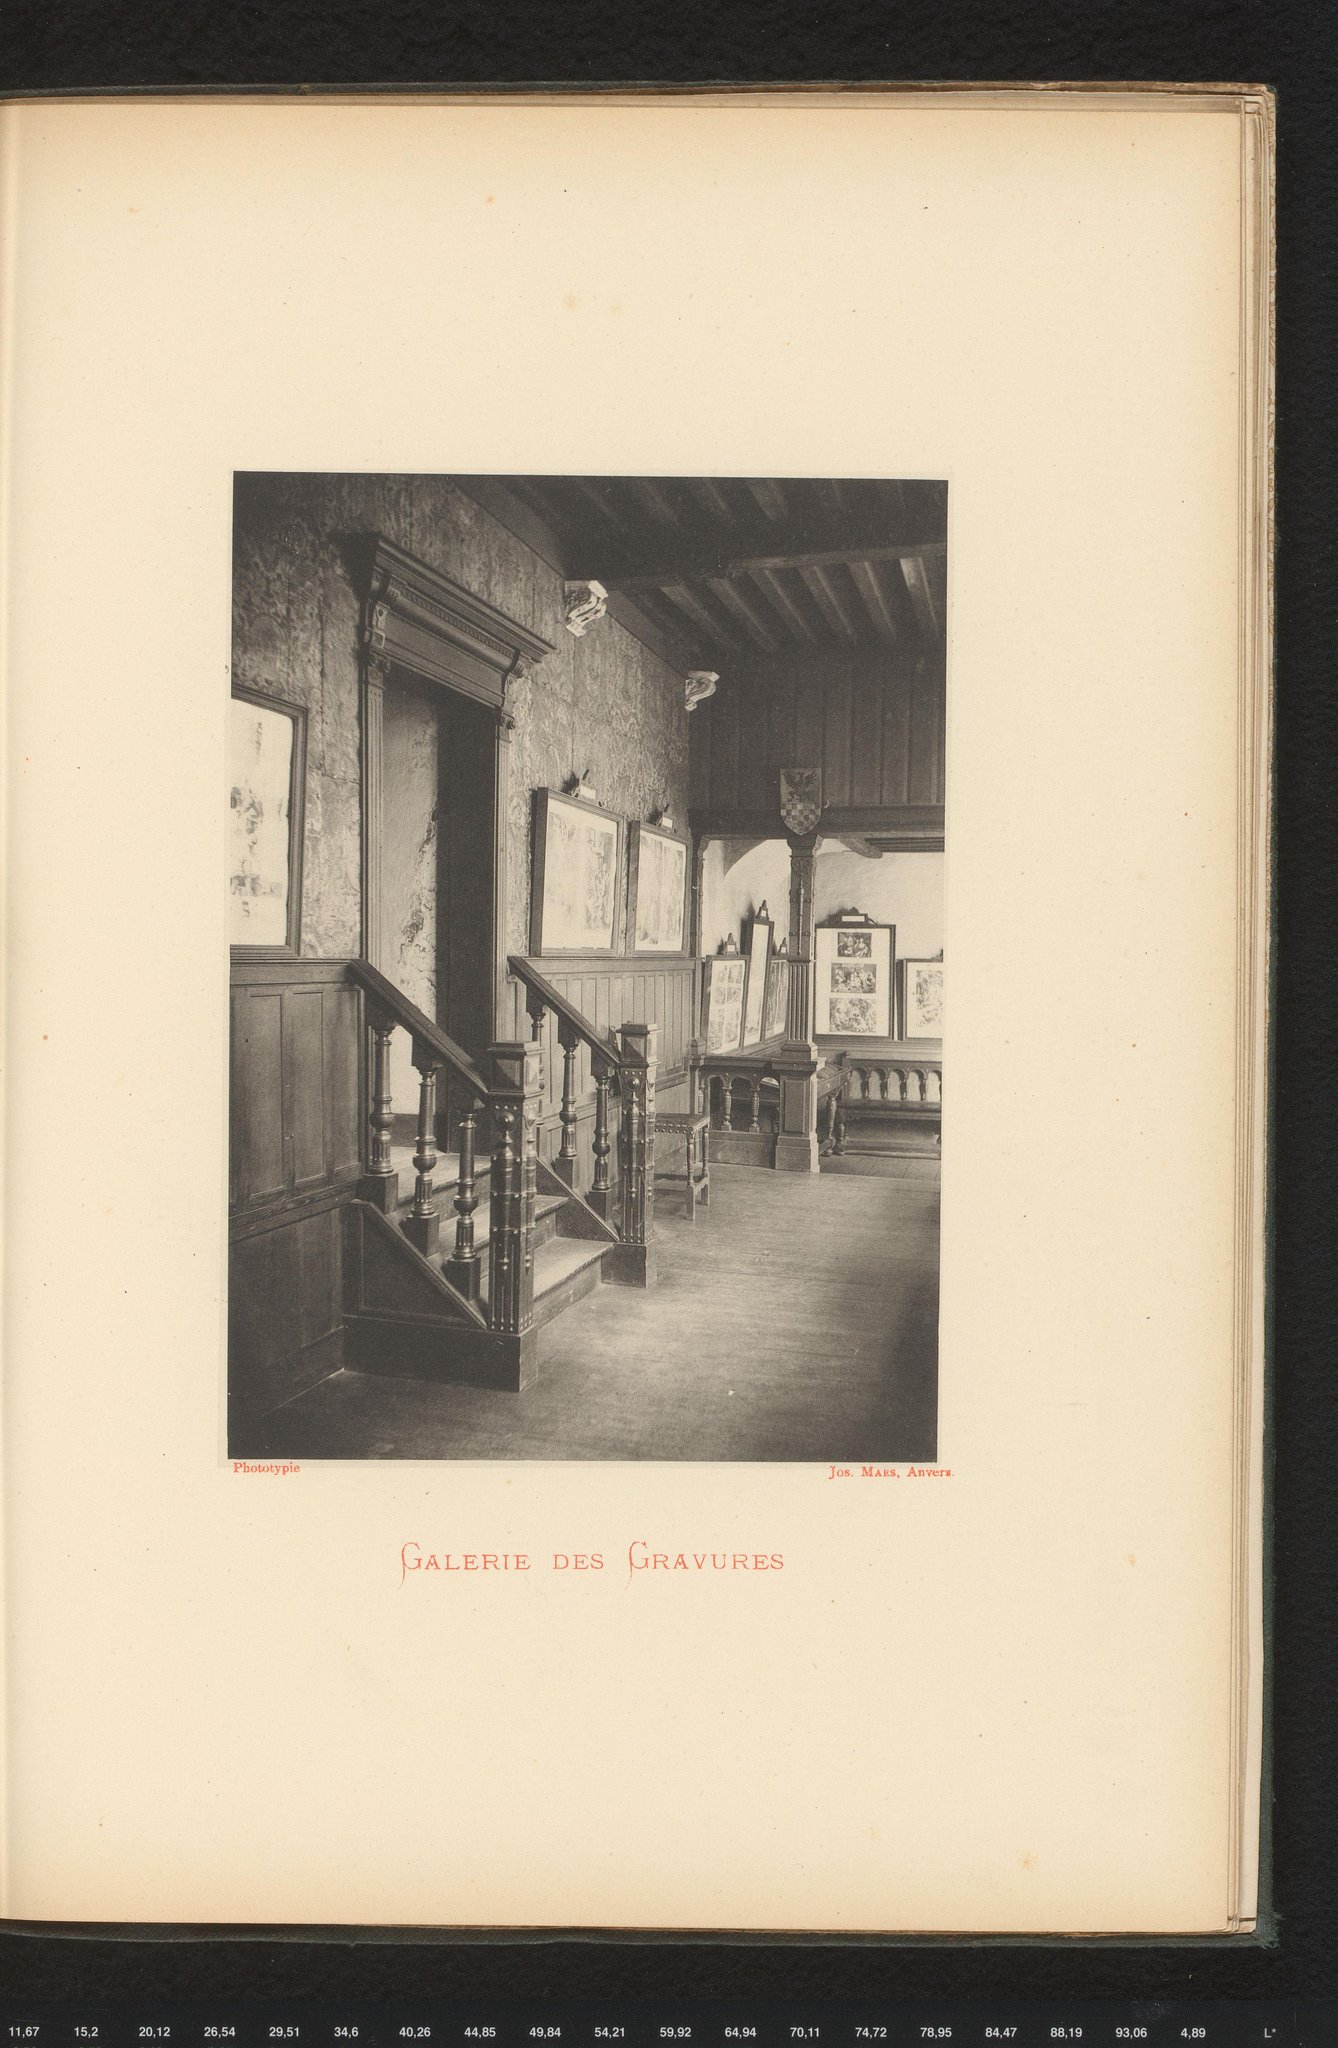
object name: page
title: Galerie des gravures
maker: joseph maes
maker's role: fotograaf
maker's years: 1838-1908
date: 1877-1882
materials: paper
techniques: photograph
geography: antwerp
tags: print, e.g.: engraving, etching, lithograph, interior of the house